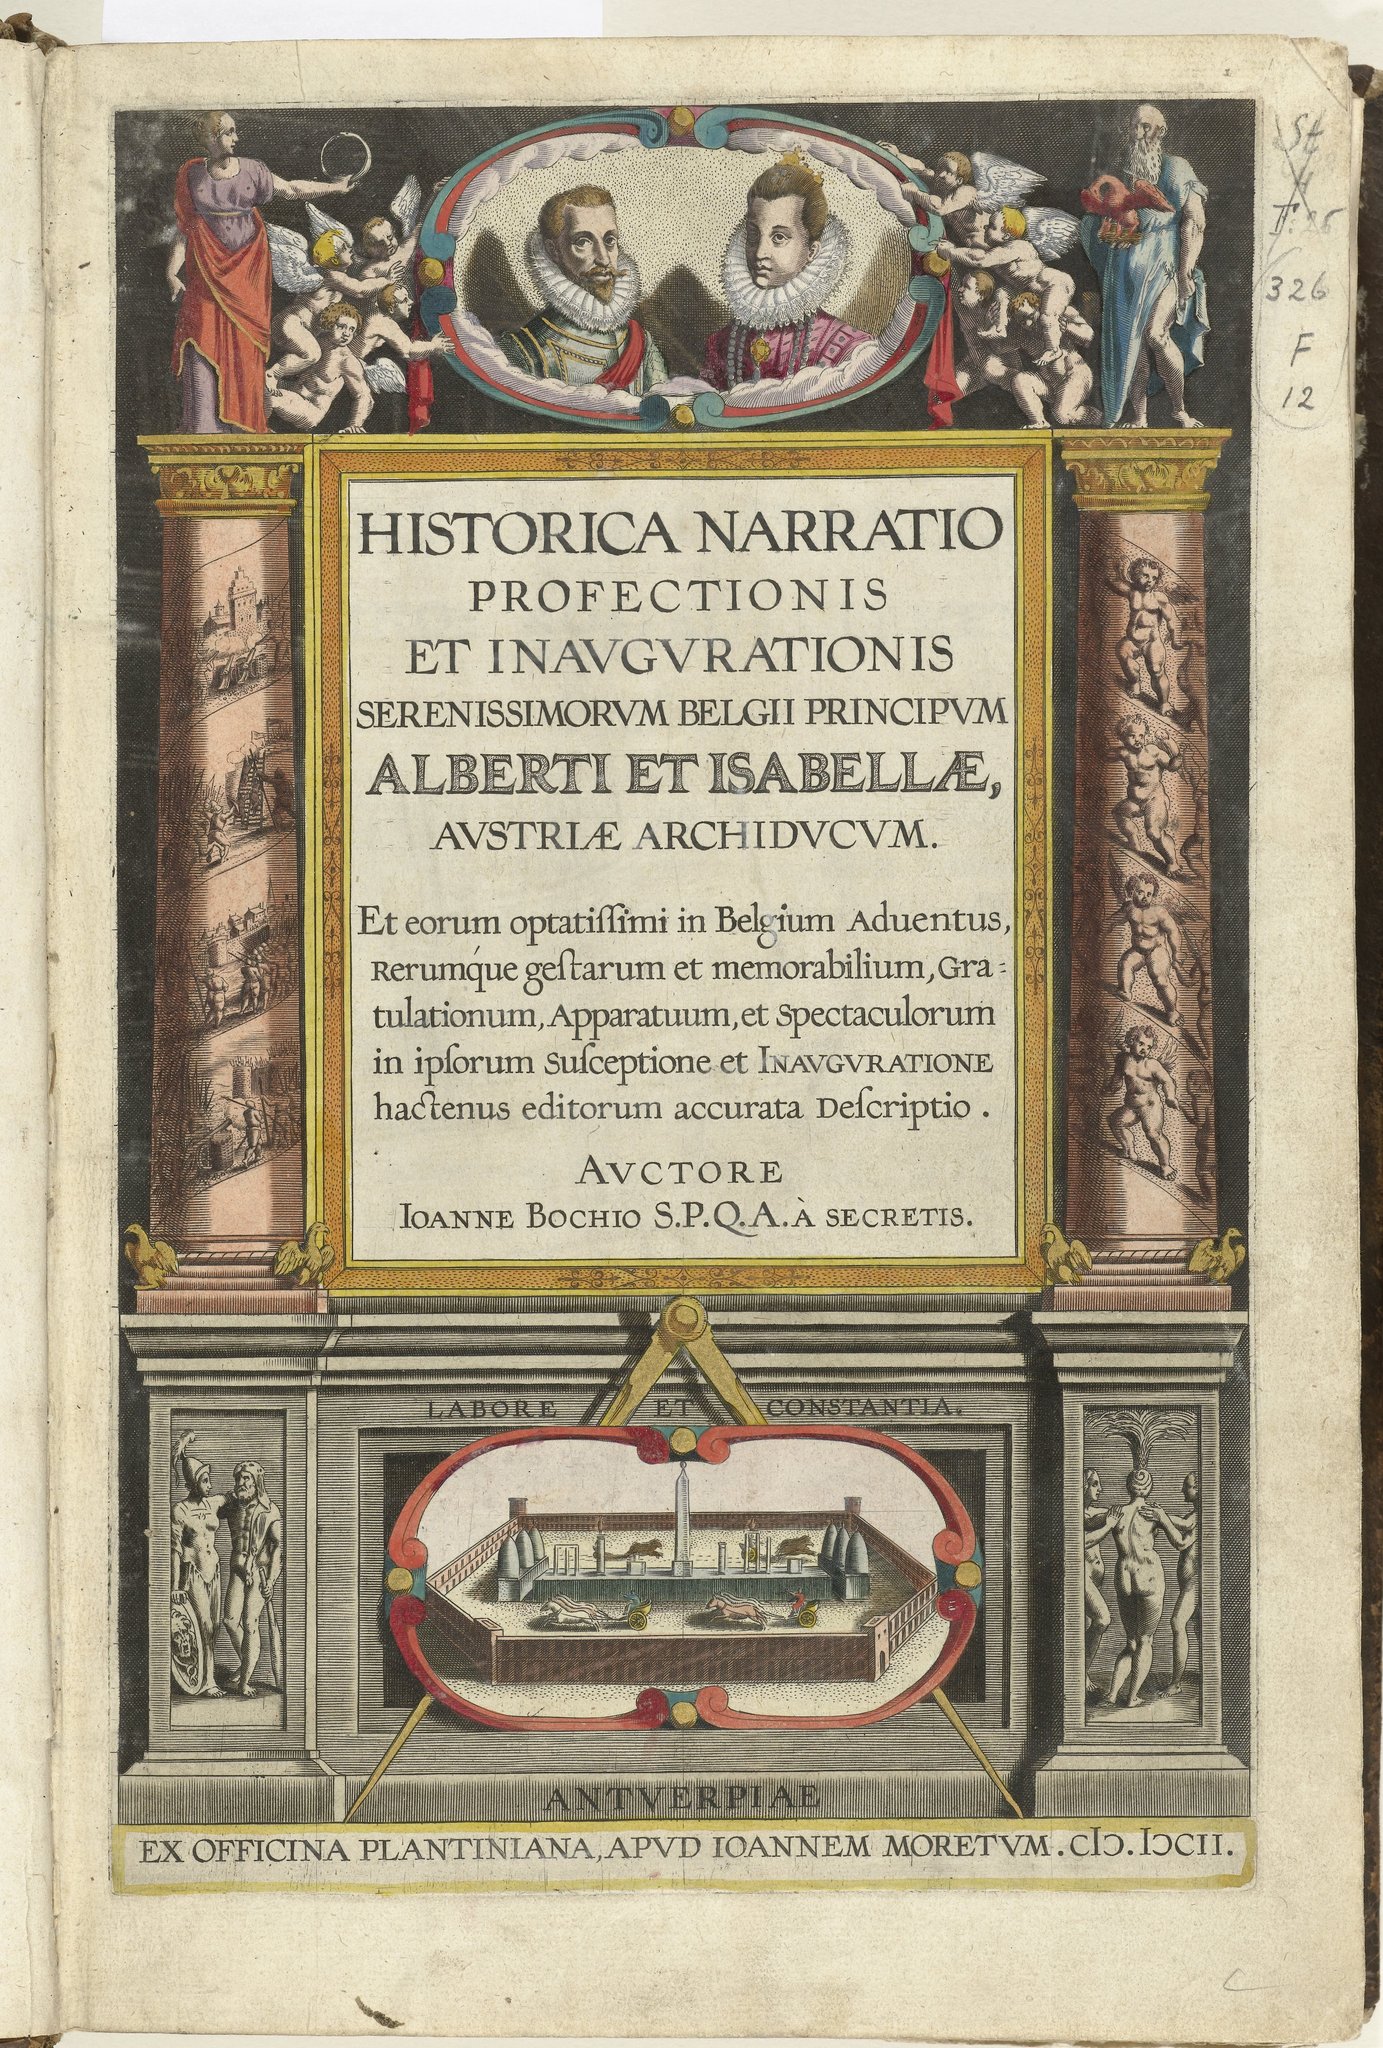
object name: print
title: Titelprent voor de beschrijving van de intocht van Albrecht en Isabella in de Zuidelijke Nederlanden, 1599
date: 1600-1602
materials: paper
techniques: engraving, hand coloring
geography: southern netherlands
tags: infante van spanje isabella clara eugenia, brussels, albrecht aartshertog van oostenrijk, wagon racing with two-wheeled vehicle, e.g.: chariot, sulky, title-page, southern netherlands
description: Titelprent voor de beschrijving van de intocht van Albrecht en Isabella de in Zuidelijke Nederlanden, december 1599. Titelprent met de Latijnse titel in een architecturale omlijsting met aan weerszijden twee zuilen met links militaire scènes en rechts putti. Bovenaan bustes van de aartshertog Albrecht van Oostenrijk en Isabella Clara Eugenia, infante van Spanje. Onderaan een hippodrome met wagenrennen. Onderdeel van: Historica narratio profectionis et inaugurationis serenissimorum Belgii principum Alberti et Isabellae Austriae archiducum, de beschrijving van de intochten van het paar te Brussel, Antwerpen, Gent en Valenciennes, 1599.